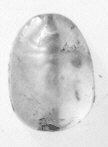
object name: stamp seal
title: Scarab seal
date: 1700-1560 BCE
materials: gemstone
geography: levant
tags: scarabs